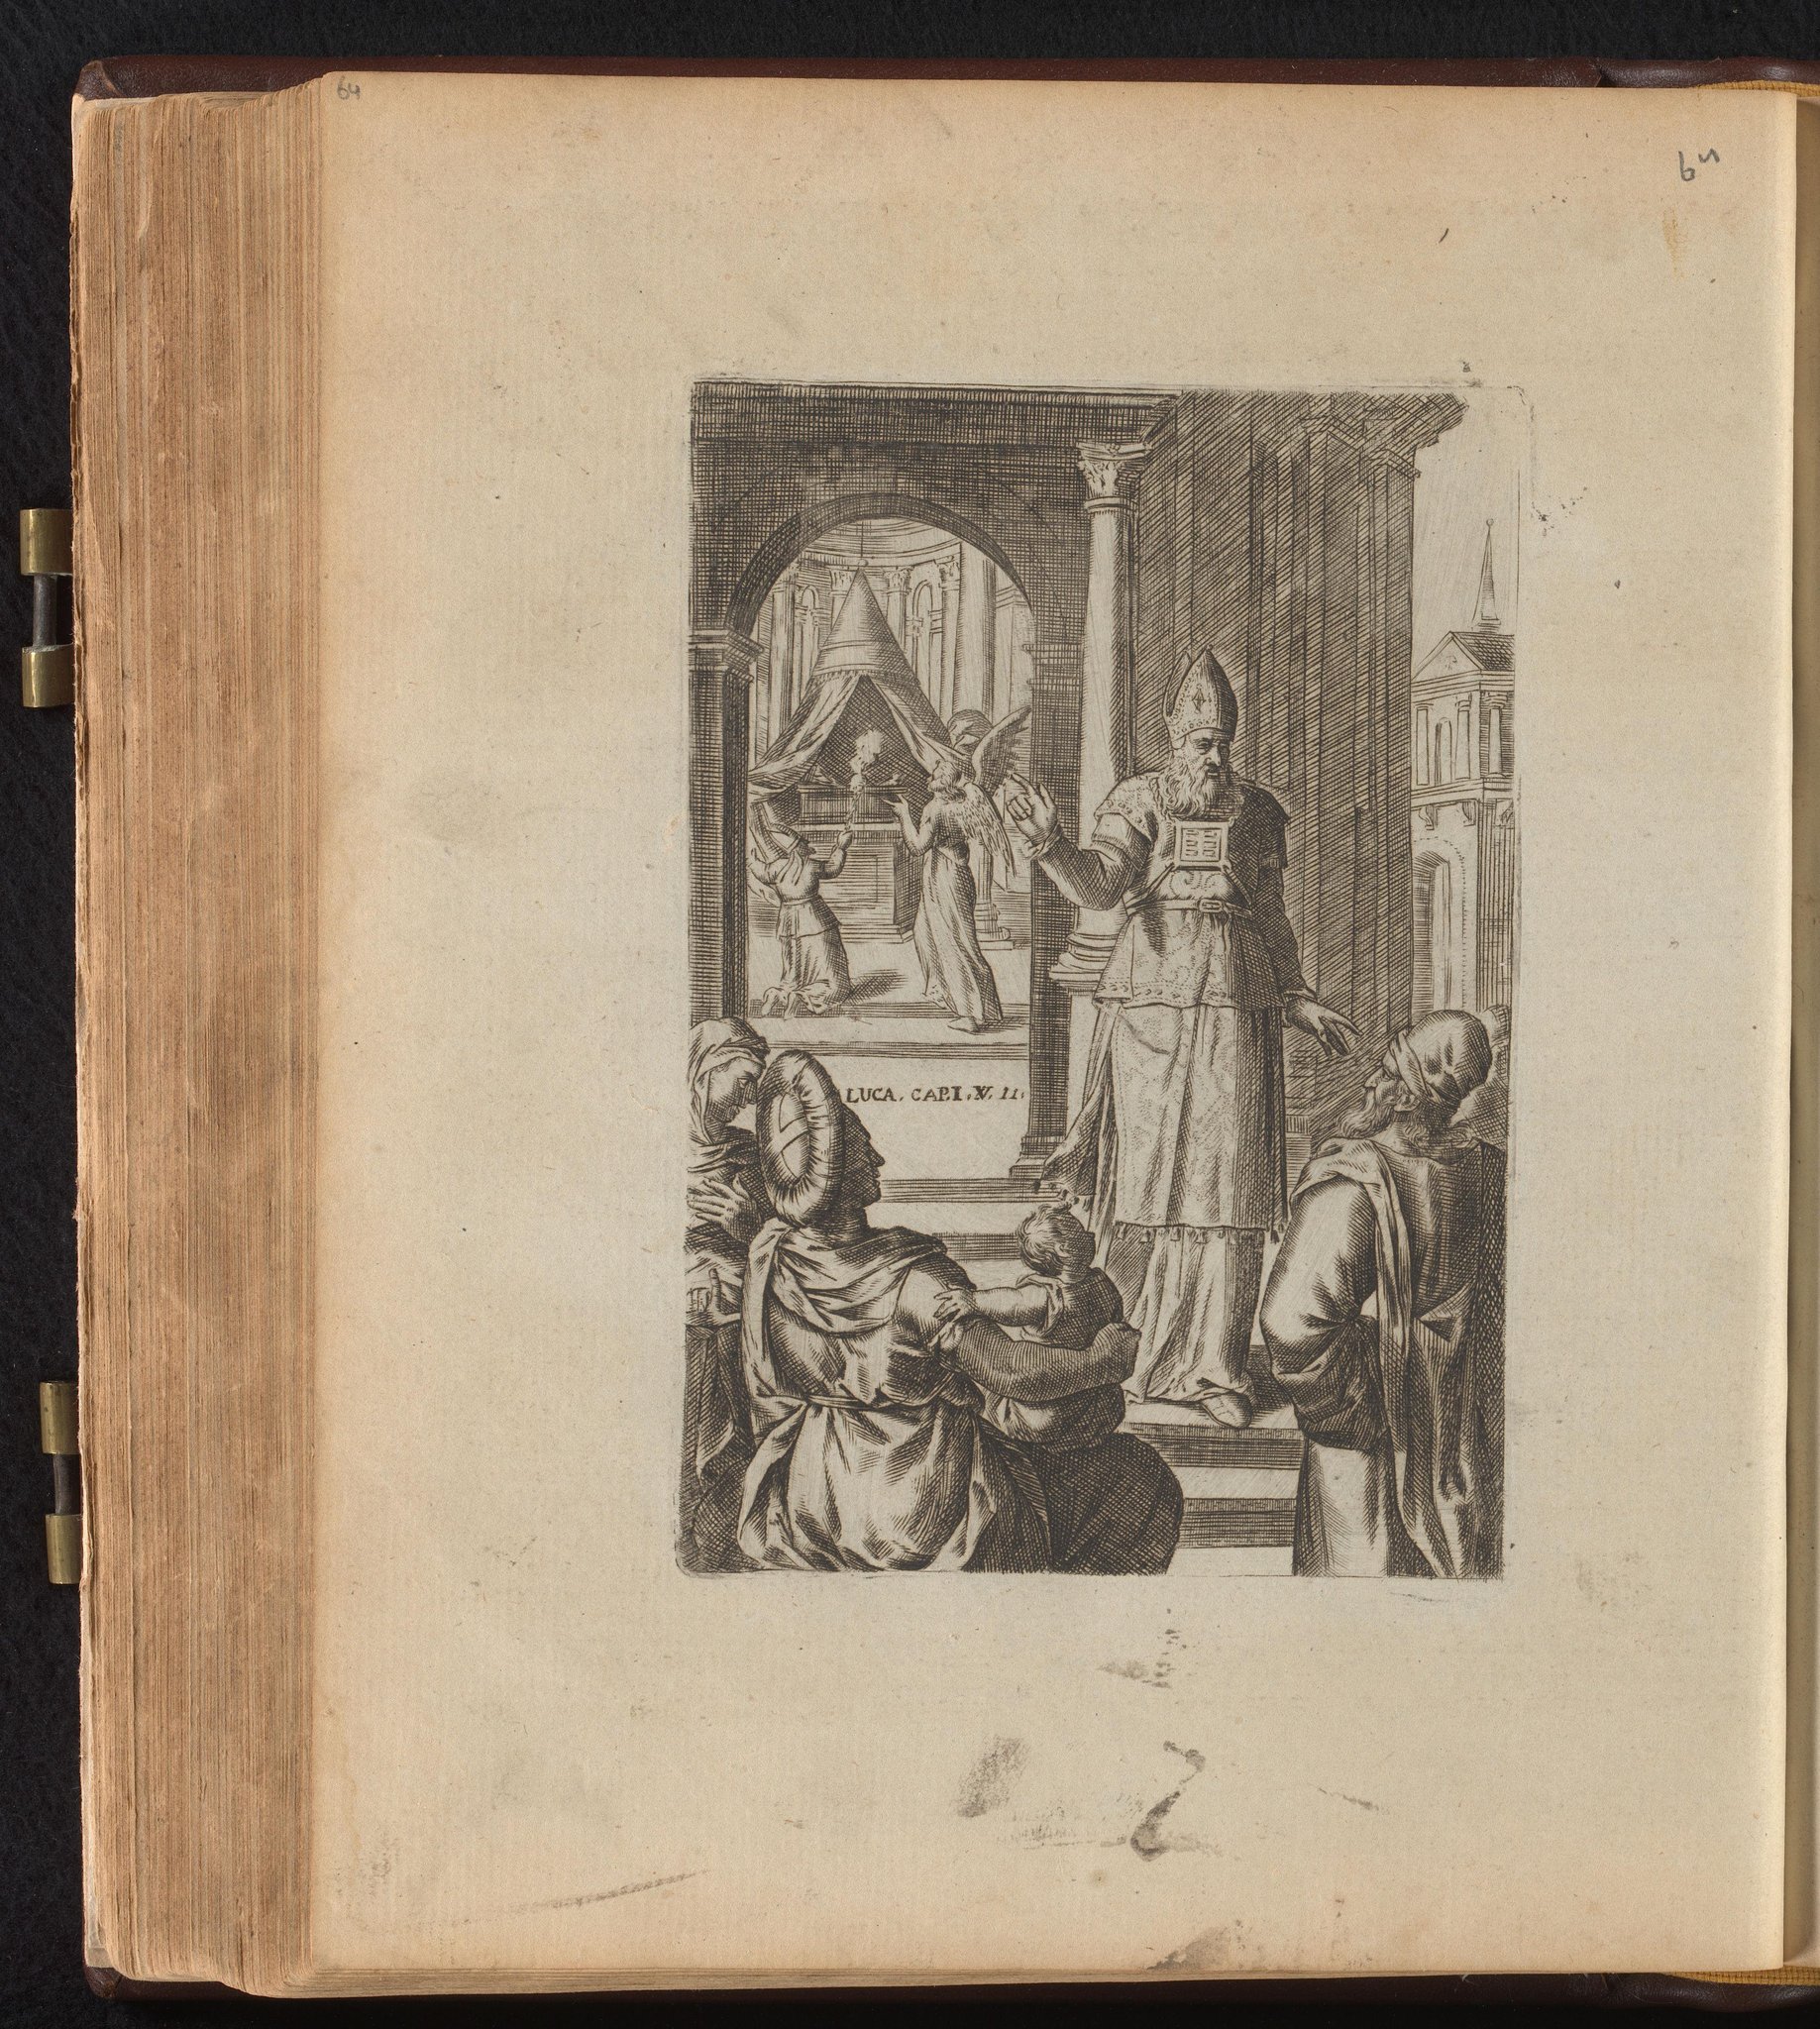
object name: album leaf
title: Aankondiging van de geboorte van Johannes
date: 1583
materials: paper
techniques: engraving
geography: antwerp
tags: zacharias speechless before the people, annunciation of the birth of john the baptist to zacharias: while he is offering incense in the temple an angel (gabriel) appears to him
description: Eerdere staat van de prent gebruikt als boekillustratie in: Biblia Sacra. Antwerpen: Christoffel Plantijn, 1583.